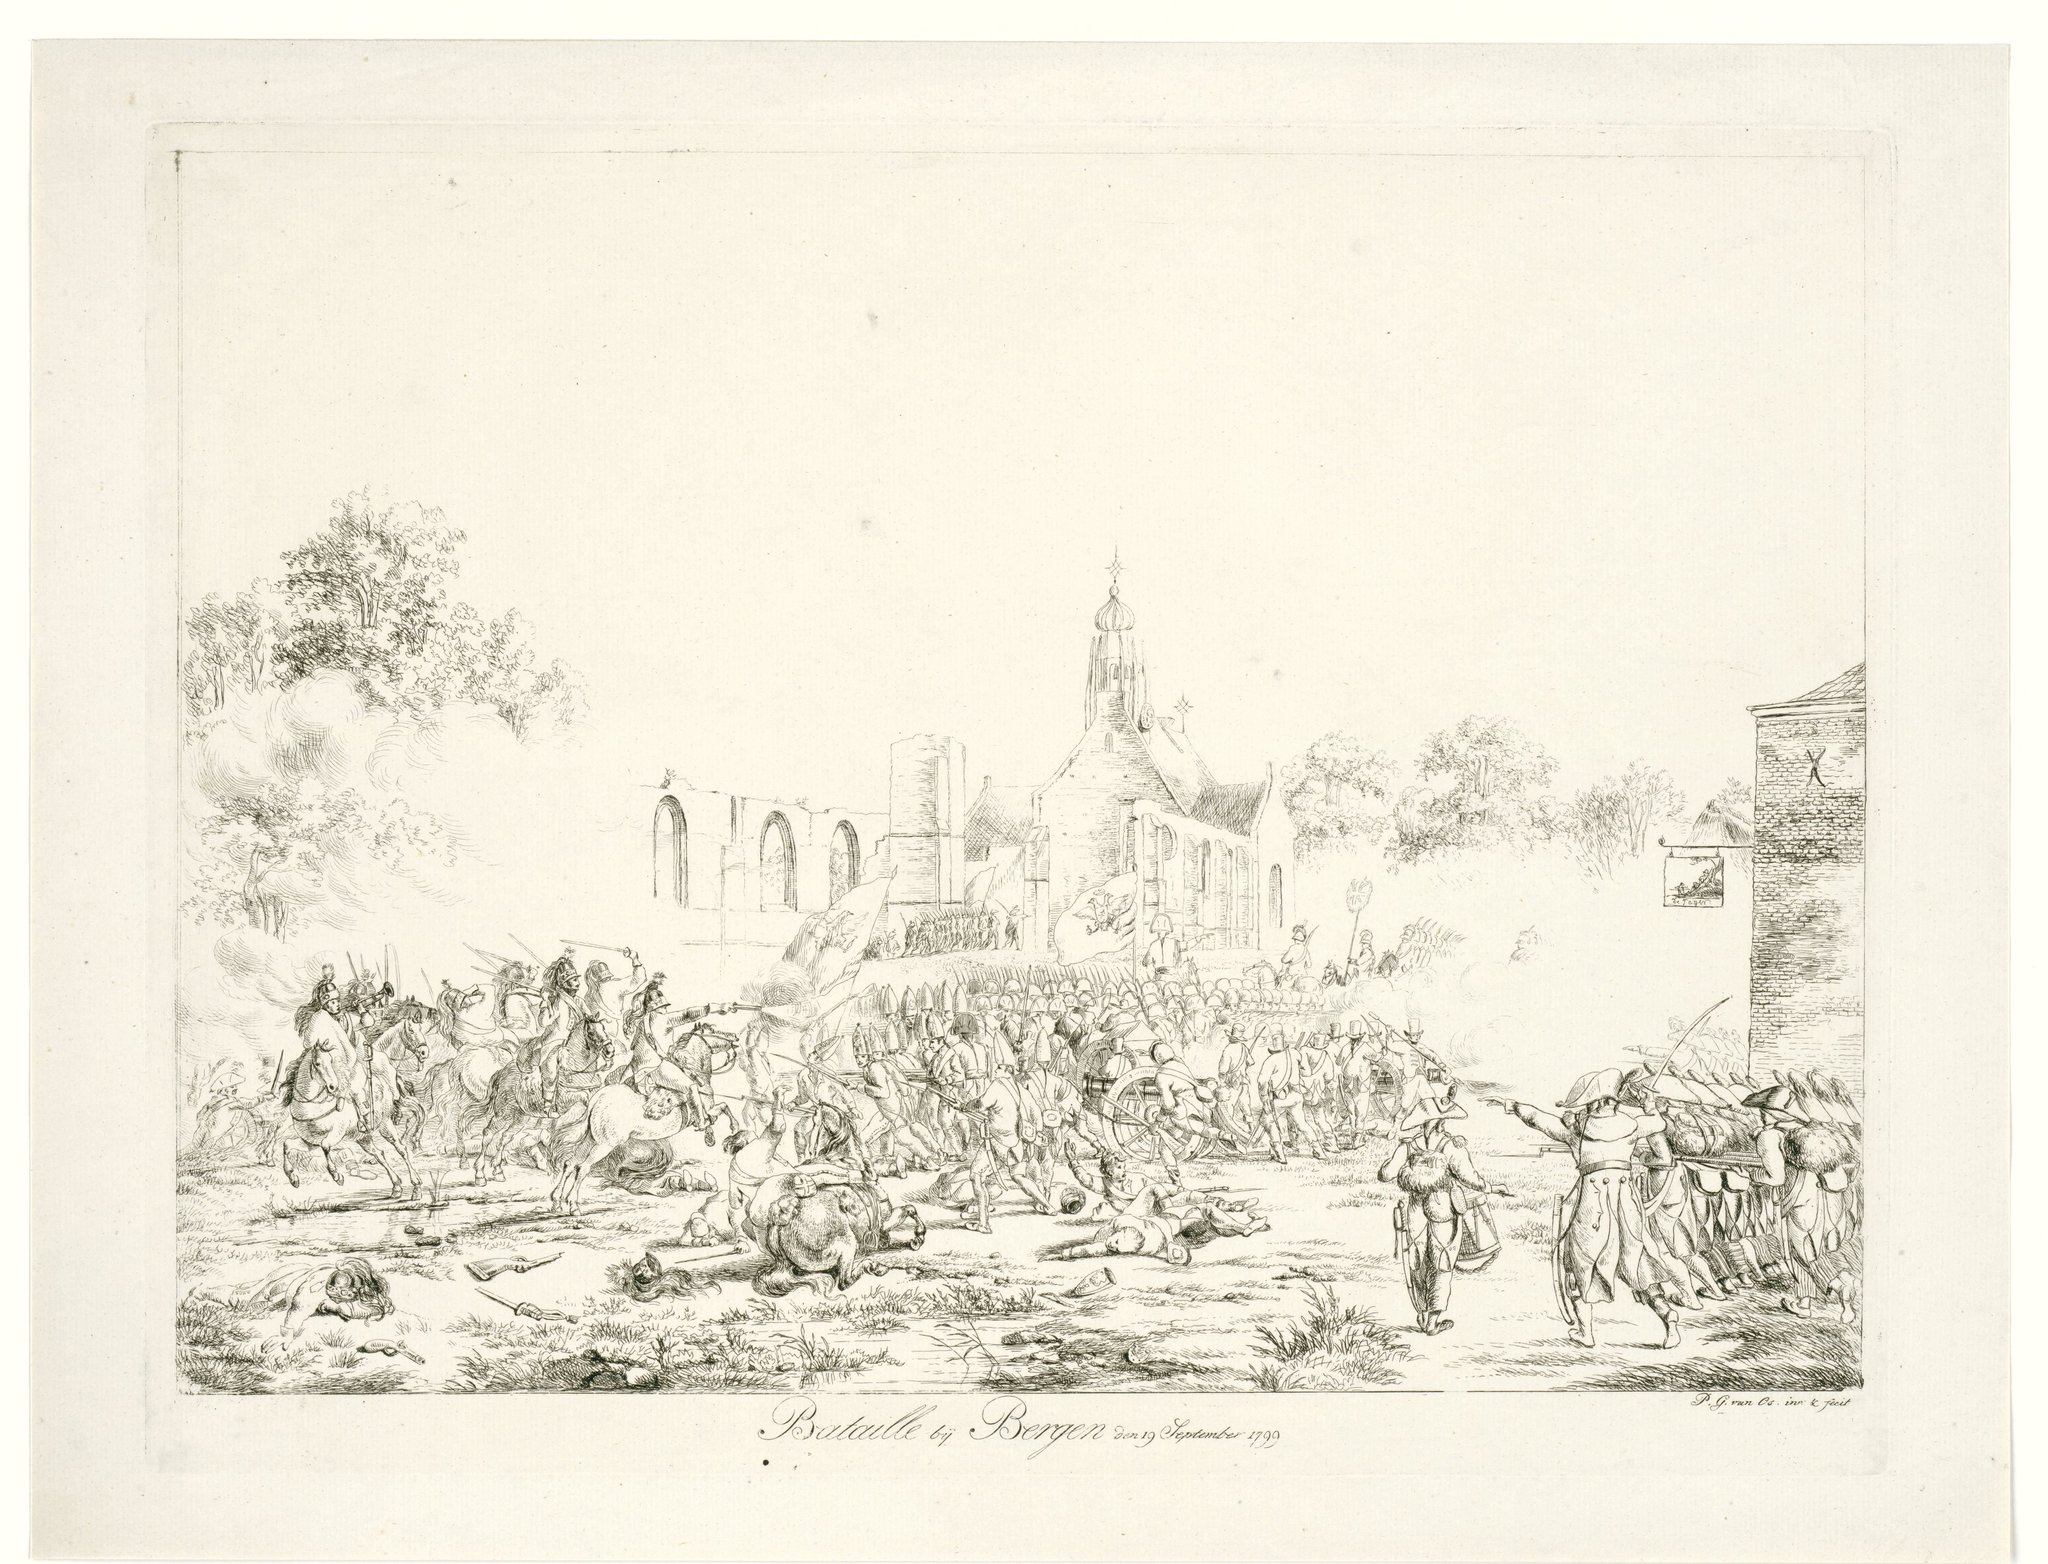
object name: print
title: Bataille bij Bergen den 19 september 1799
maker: pieter gerardus van os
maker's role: draughtsman, painter, print maker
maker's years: 1776-1839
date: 1799-1801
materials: paper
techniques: etching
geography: netherlands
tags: battle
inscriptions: collector's mark: Lugt 2228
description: Gezicht op het slagveld in het centrum van Bergen. Het Frans-Bataafse leger strijdt tegen de Engelsen en Russen. Rechtsvoor infanterie, linksvoor cavalerie. Op de achtergrond de Bergense ruïnekerk.